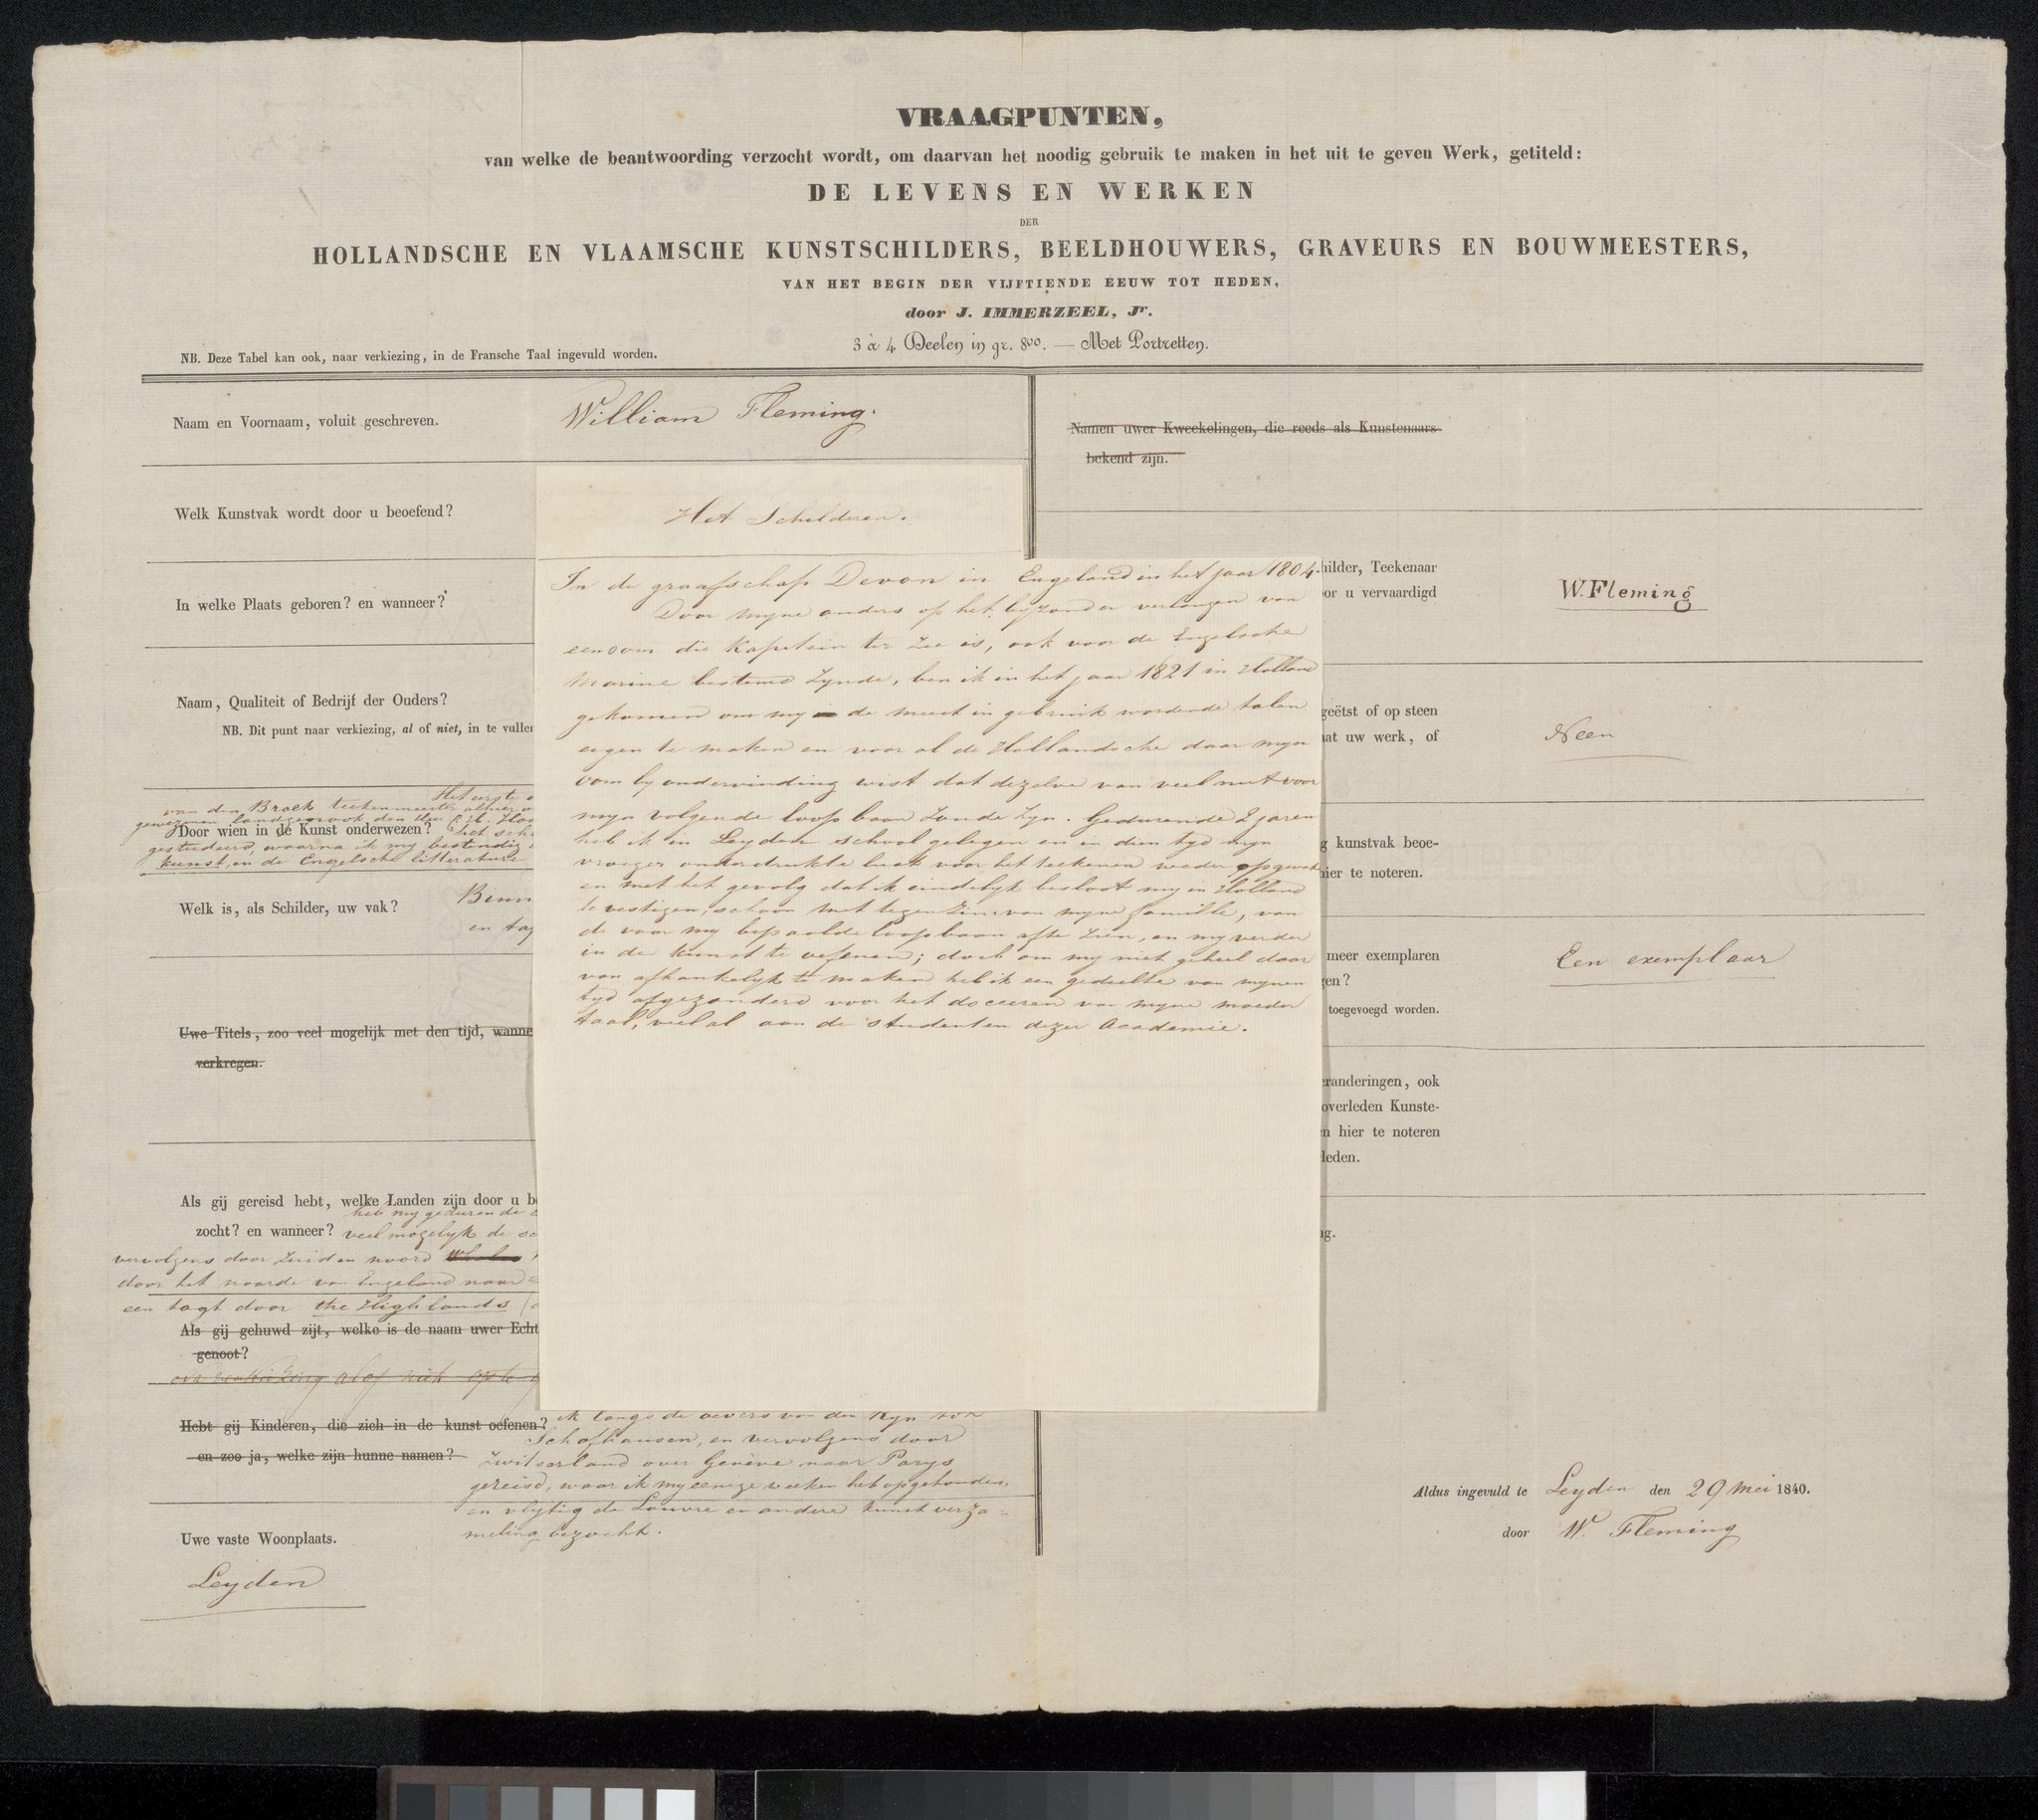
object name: manuscript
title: Enquêteformulier ingevuld door William Fleming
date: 1840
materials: ink, paper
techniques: pen, printing, writing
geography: leiden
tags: painter, william fleming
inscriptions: inscription: ‘Vraagpunten,/ van welke de beantwoording verzocht wordt, om daarvan het noodig gebruik te maken in het uit te geven Werk, getiteld: De levens en werken/ der Hollandsche en Vlaamsche kunstschilders, beeldhouwers,/ graveurs en bouwmeesters, van het begin der vijftiende eeuw tot heden/ door J. Immerzeel, Jr.’, watermark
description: Opgenomen in: Immerzeel, J. Jr., De levens en werken der Hollandsche en Vlaamsche kunstschilders, beeldhouwers, graveurs en bouwmeesters, van het begin der vijftiende eeuw tot heden, Amsterdam: J.C. van Kesteren, 1842-1843.